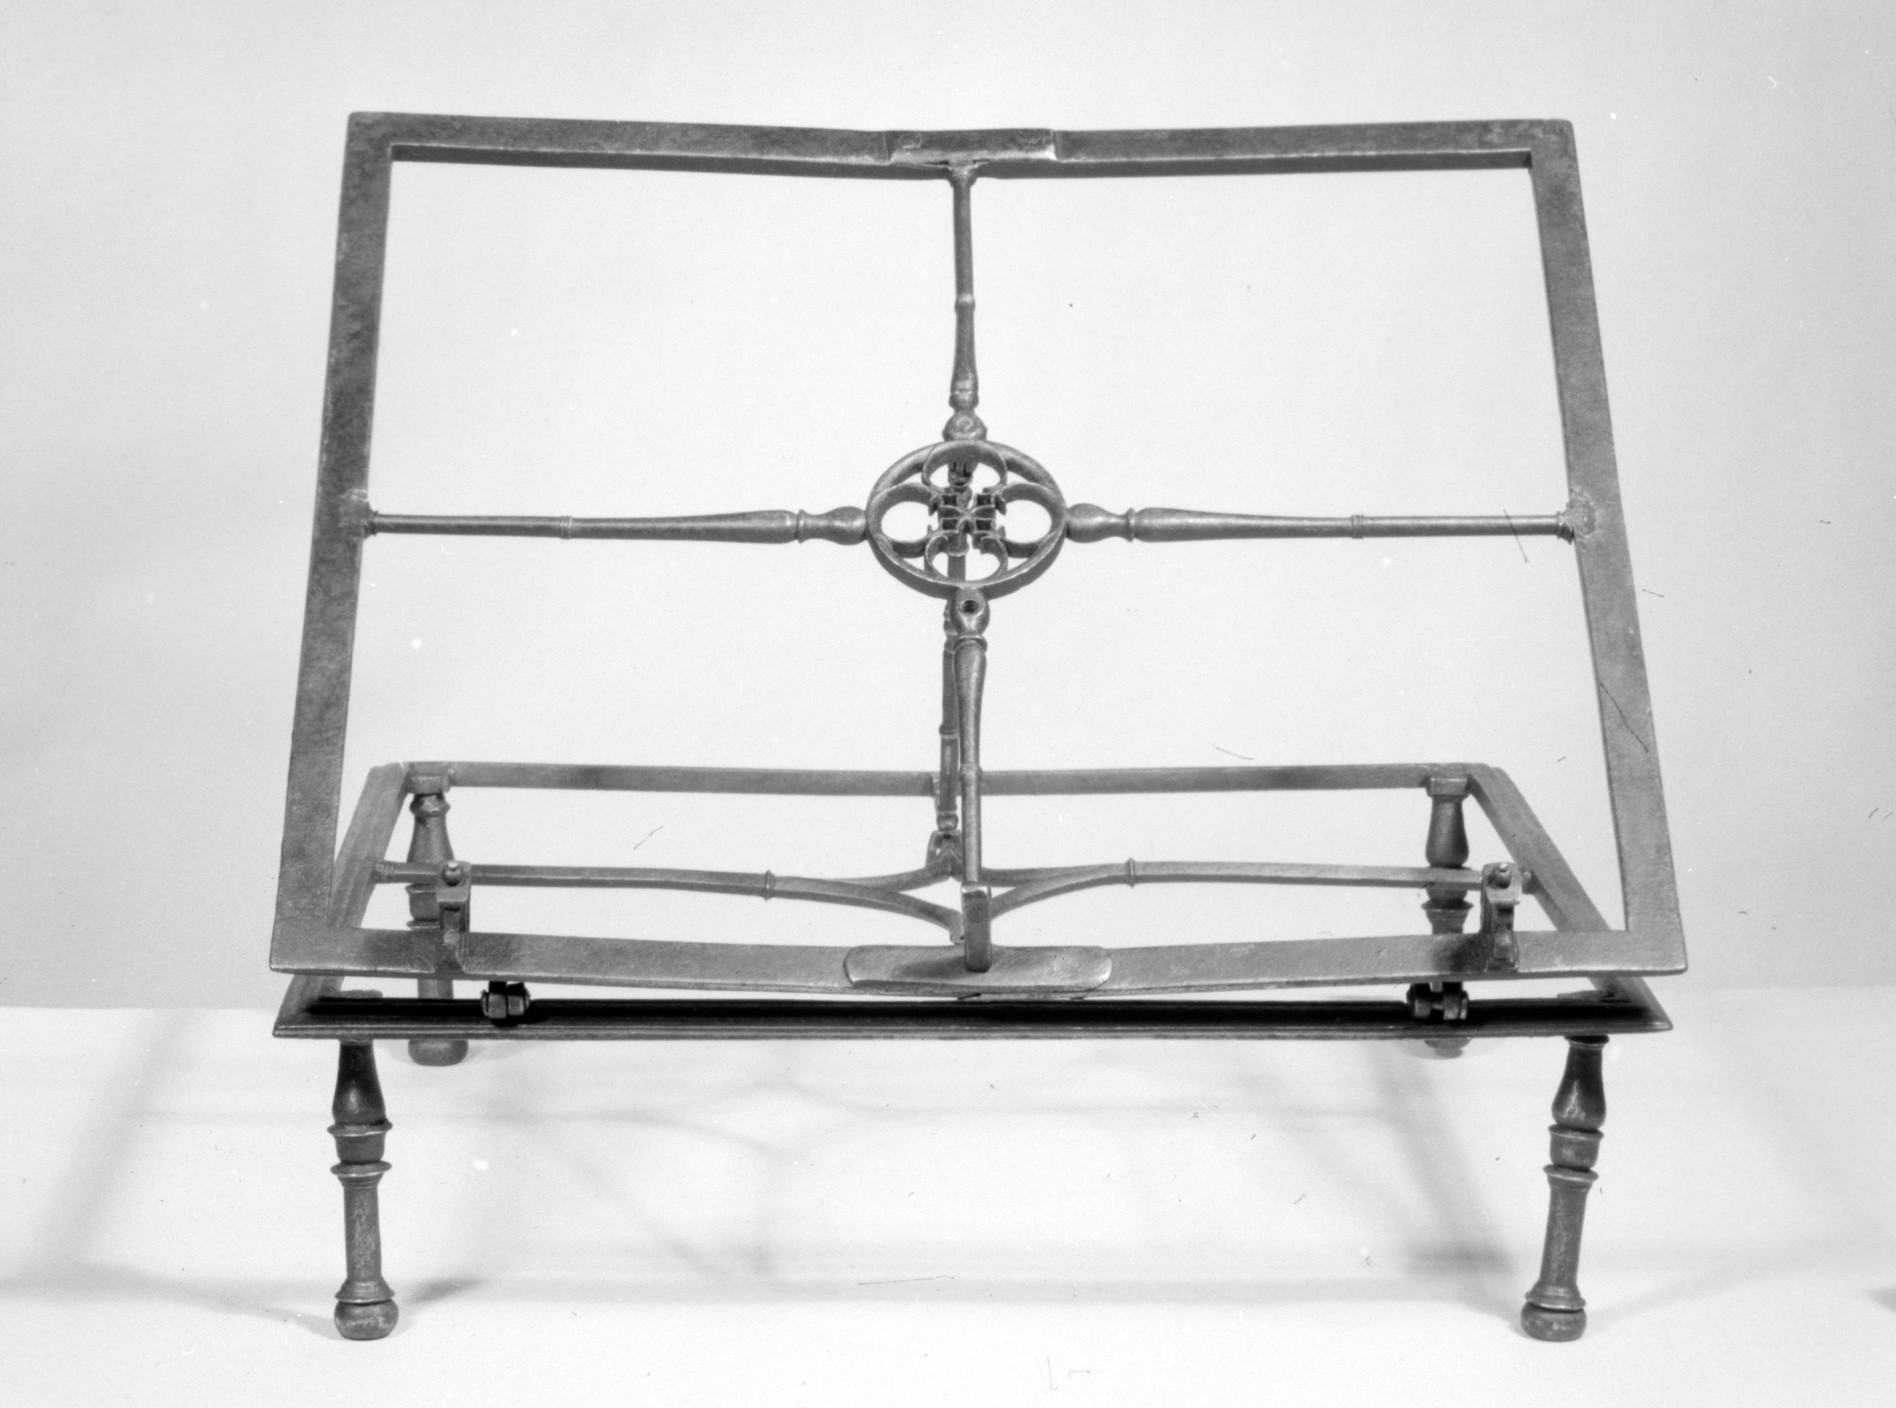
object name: lectern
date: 1501-1533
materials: iron